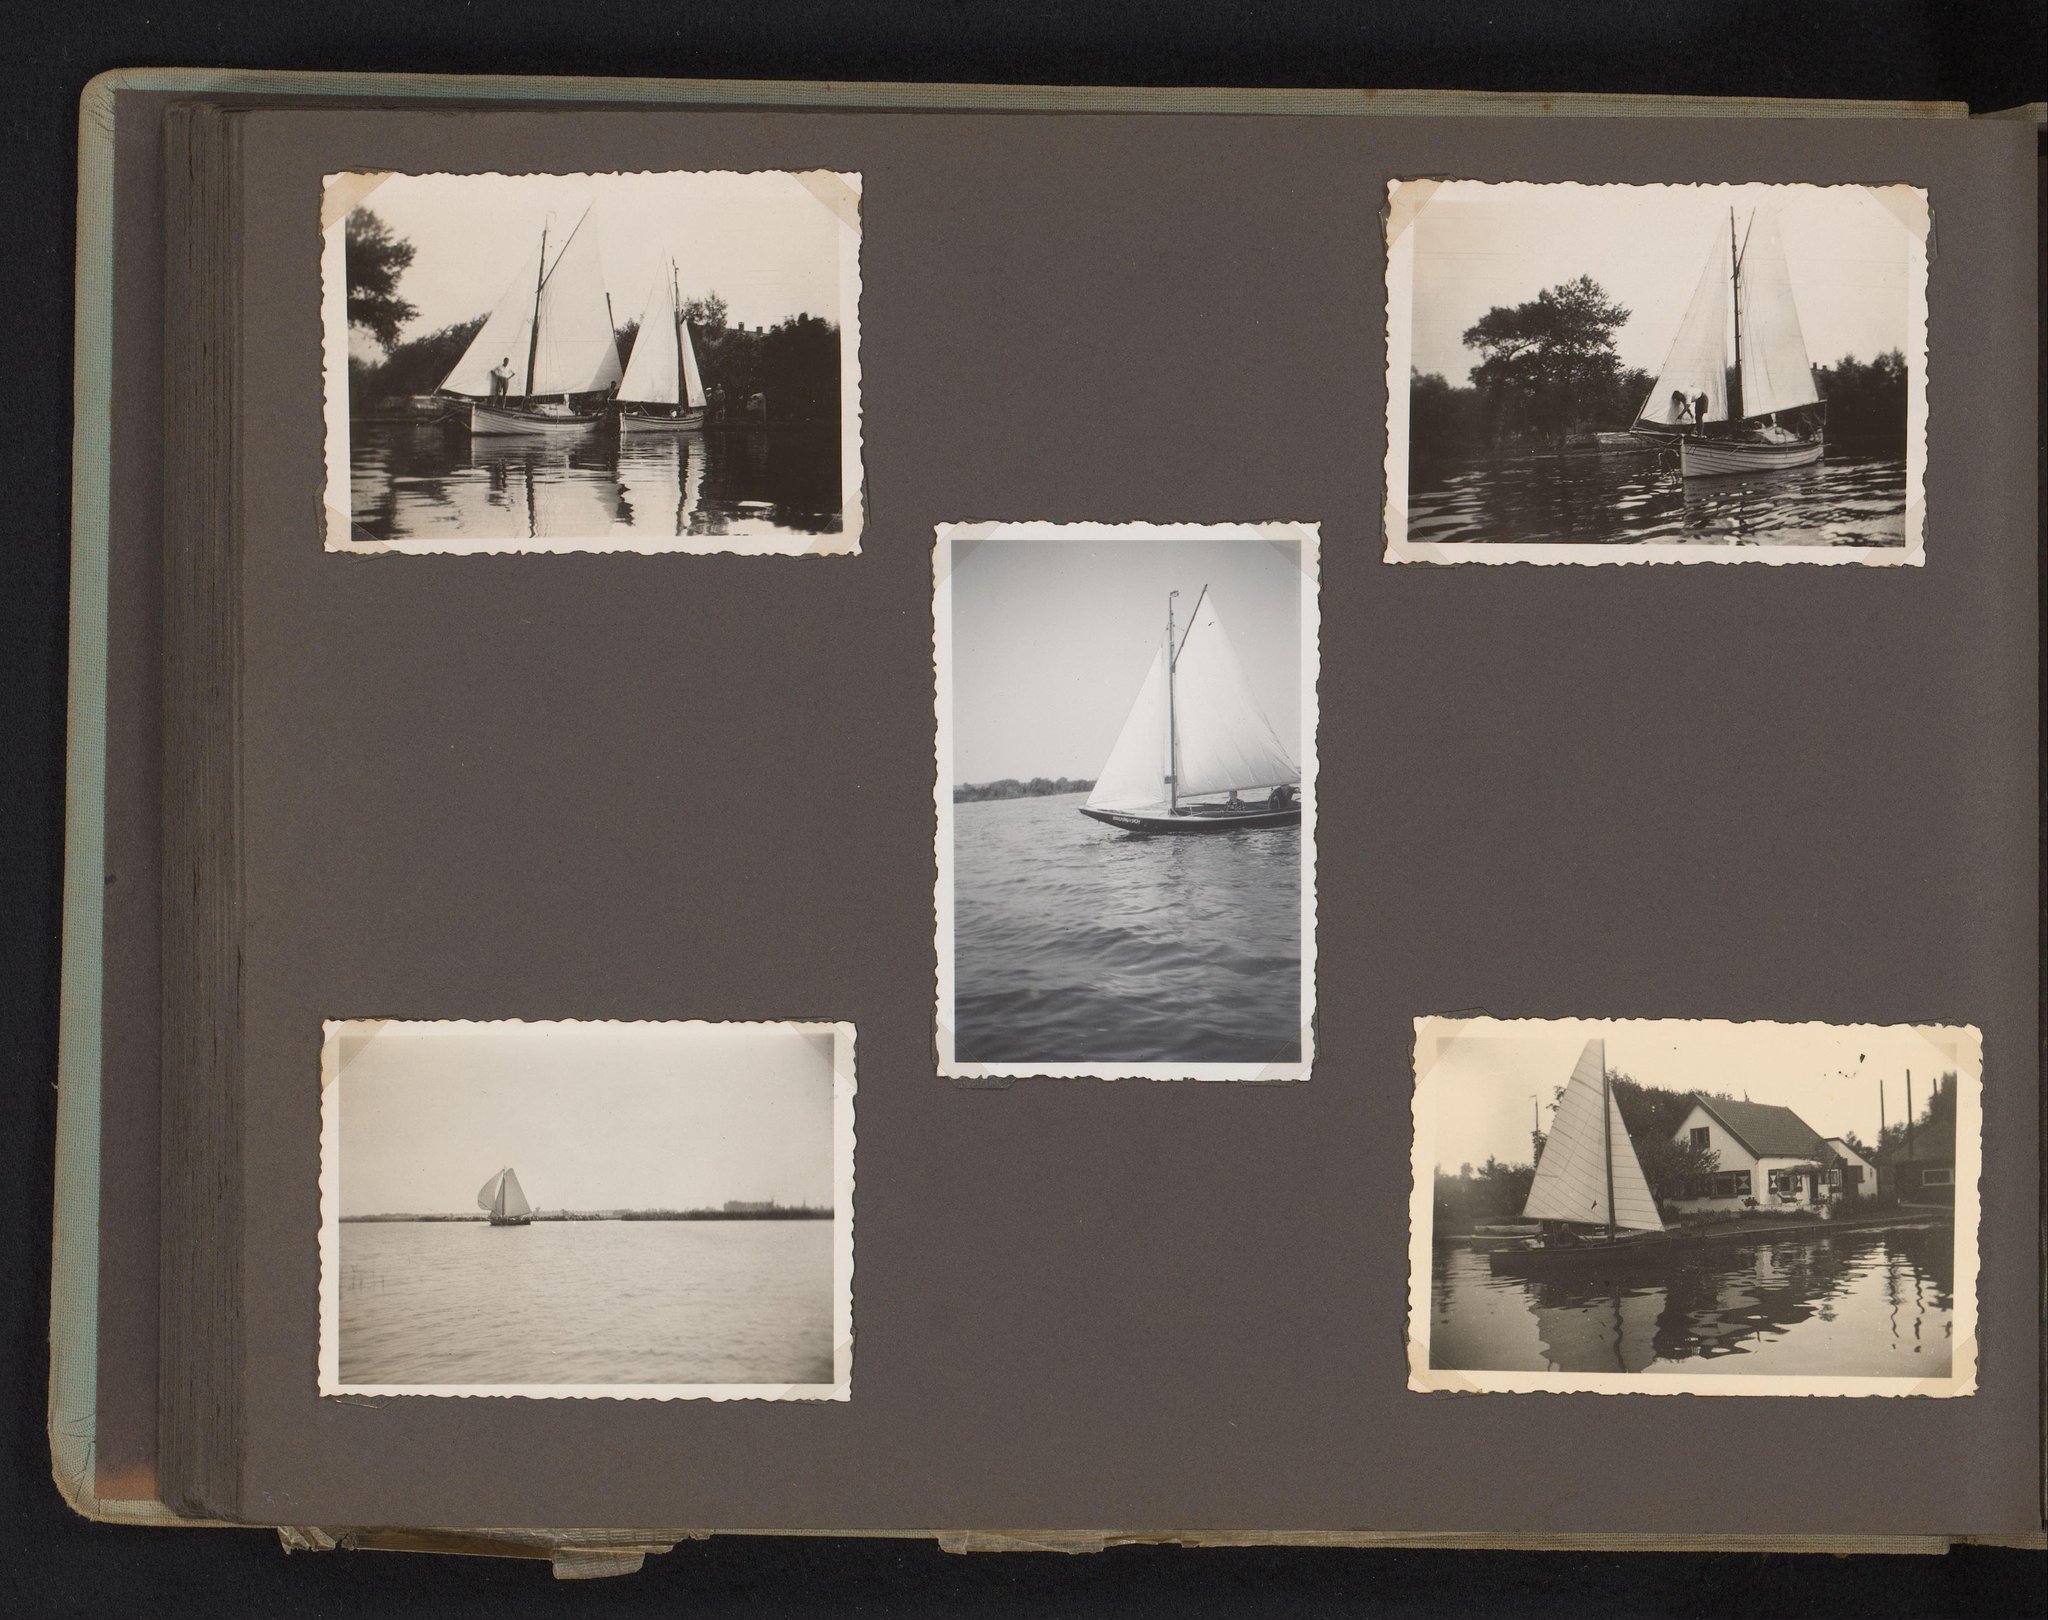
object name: album leaf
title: Zeilvakantie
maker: Anonymous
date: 1935-1945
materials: cardboard, photographic support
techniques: gelatin silver print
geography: netherlands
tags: sailing-ship, sailing-boat, outing, pleasure trip, netherlands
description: Albumblad met vijf foto's van een zeilvakantie. Onderdeel van het fotoalbum van een jonge vrouw, ca. 1935-1945.